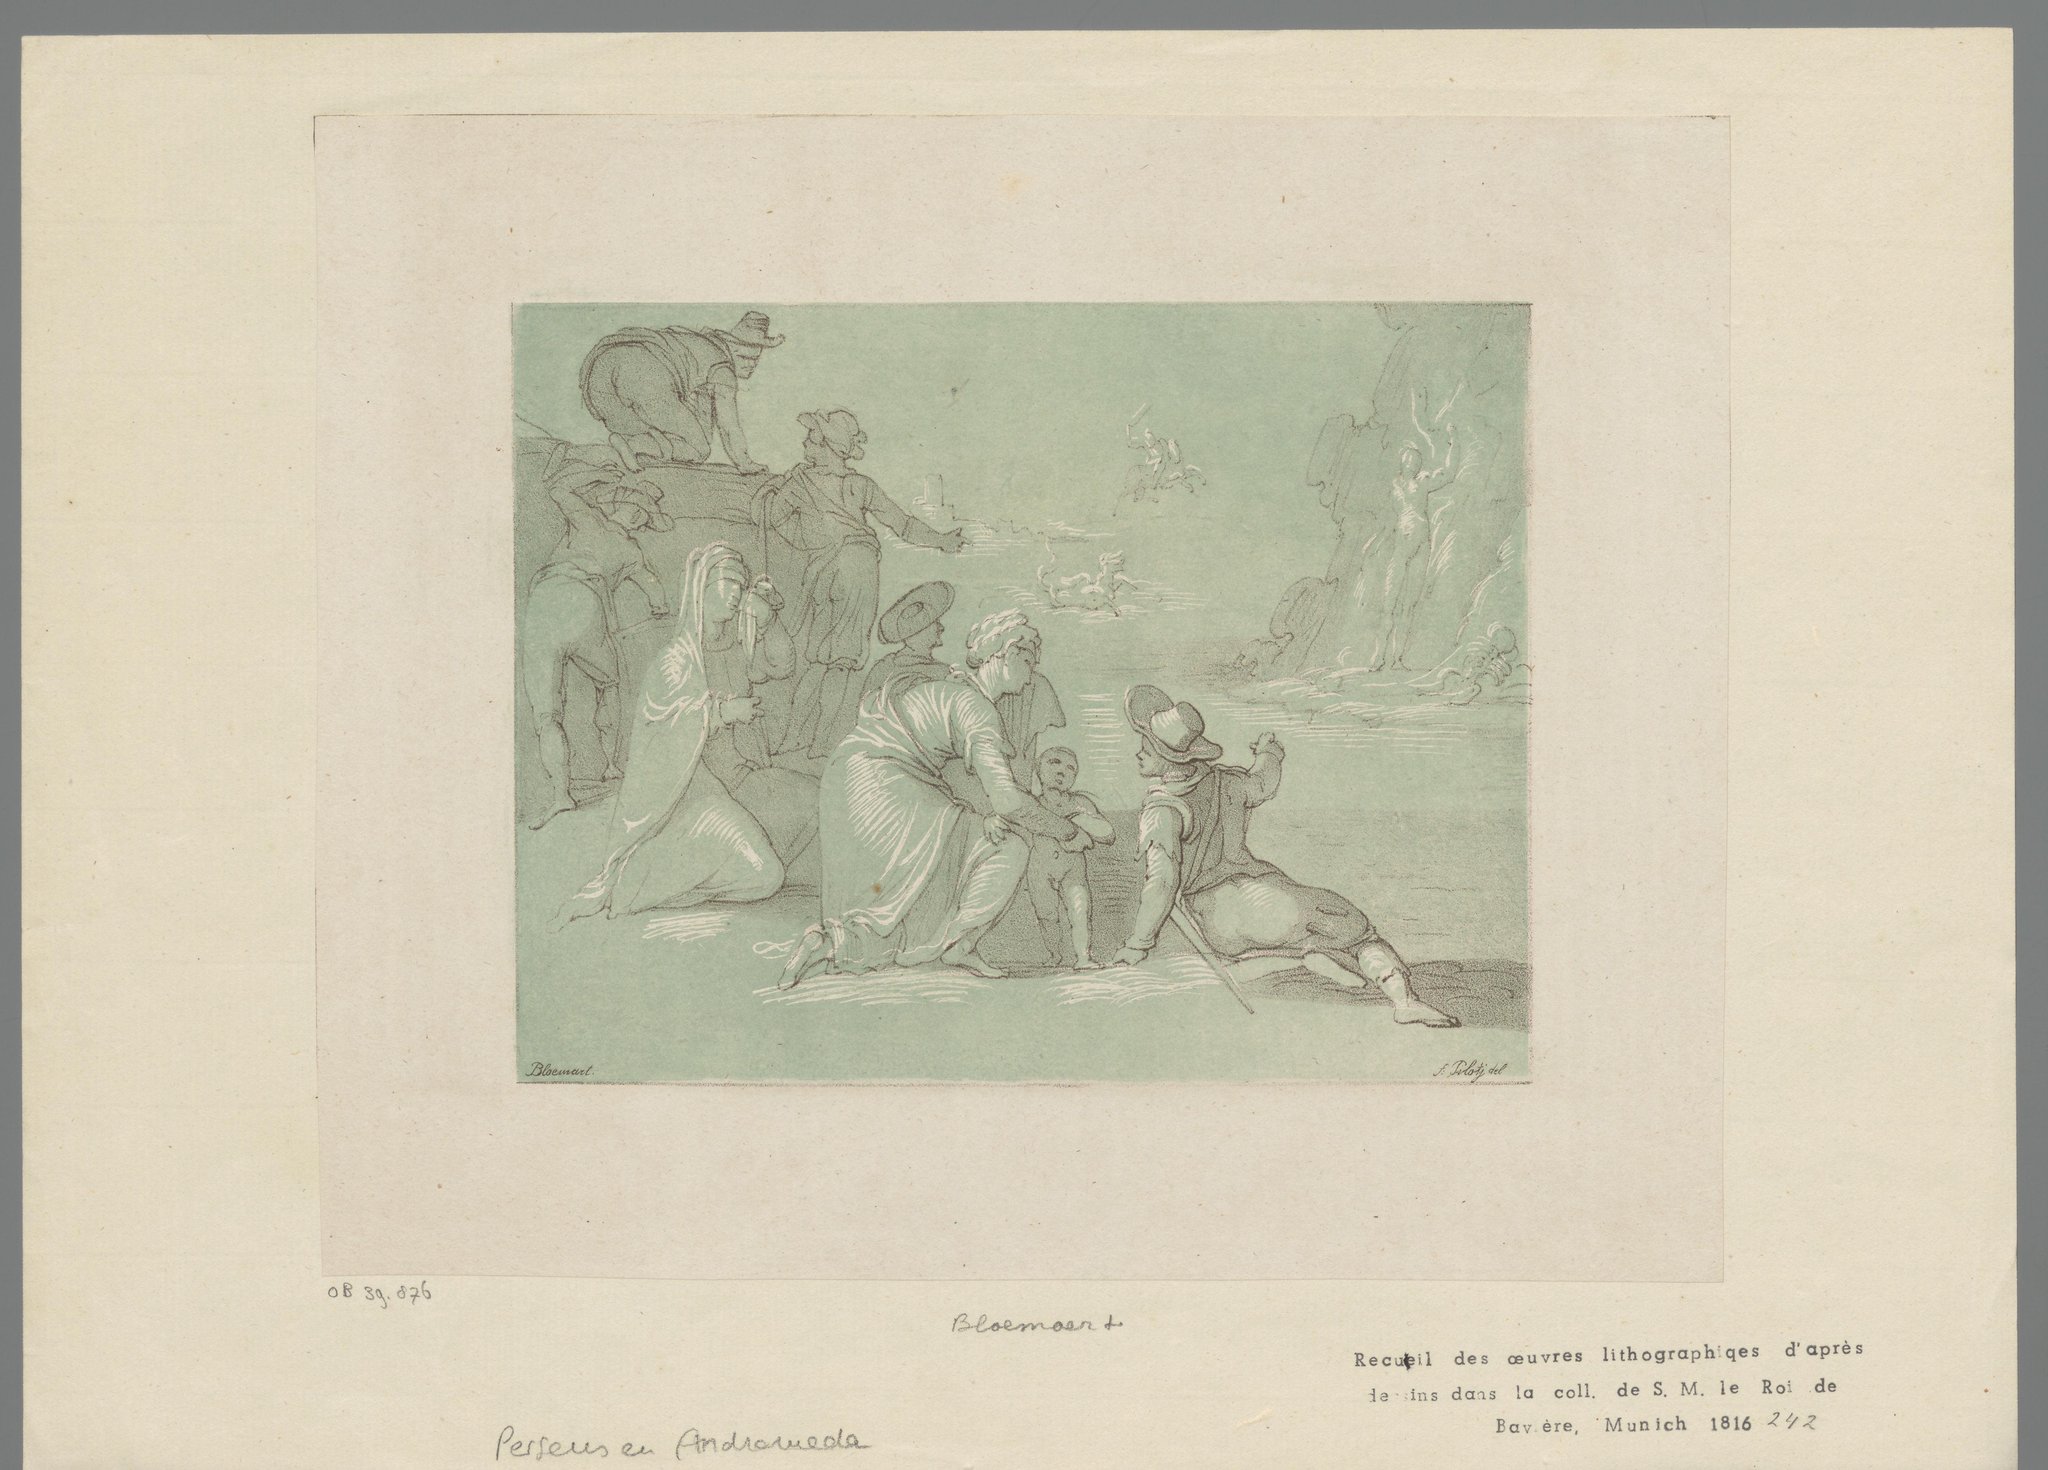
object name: print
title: Les Oeuvres Lithographiques, choix de dessins d'après les grands maitres de toutes les Ecoles, tirées du Musée de S.M. le roi de Bavière par Strixner, Piloty et Cie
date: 1810-1816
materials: paper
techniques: tone lithography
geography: munich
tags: perseus kills the sea monster (or turns it into stone by showing it the gorgon's head) to release andromeda; sometimes her parents cepheus and cassiopea watch the scene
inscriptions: collector's mark: Lugt 2166, inscription: ‘Recueil des oeuvres lithographiqes d'arpes de sins dans la coll. de S.M. le Roi de Bavière, Munich 1816’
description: Prent behoort tot de serie 'Les Oeuvres Lithographiques, choix de dessins d'après les grands maitres de toutes les Ecoles, tirées du Musée de S.M. le roi de Bavière par Strixner, Piloty et Cie'. Deze serie werd door J. Stunz in München in 72 delen van elk zes bladen gepubliceerd tussen 1810 en 1816; in totaal 432 prenten. Mogelijk is dit prent 242.